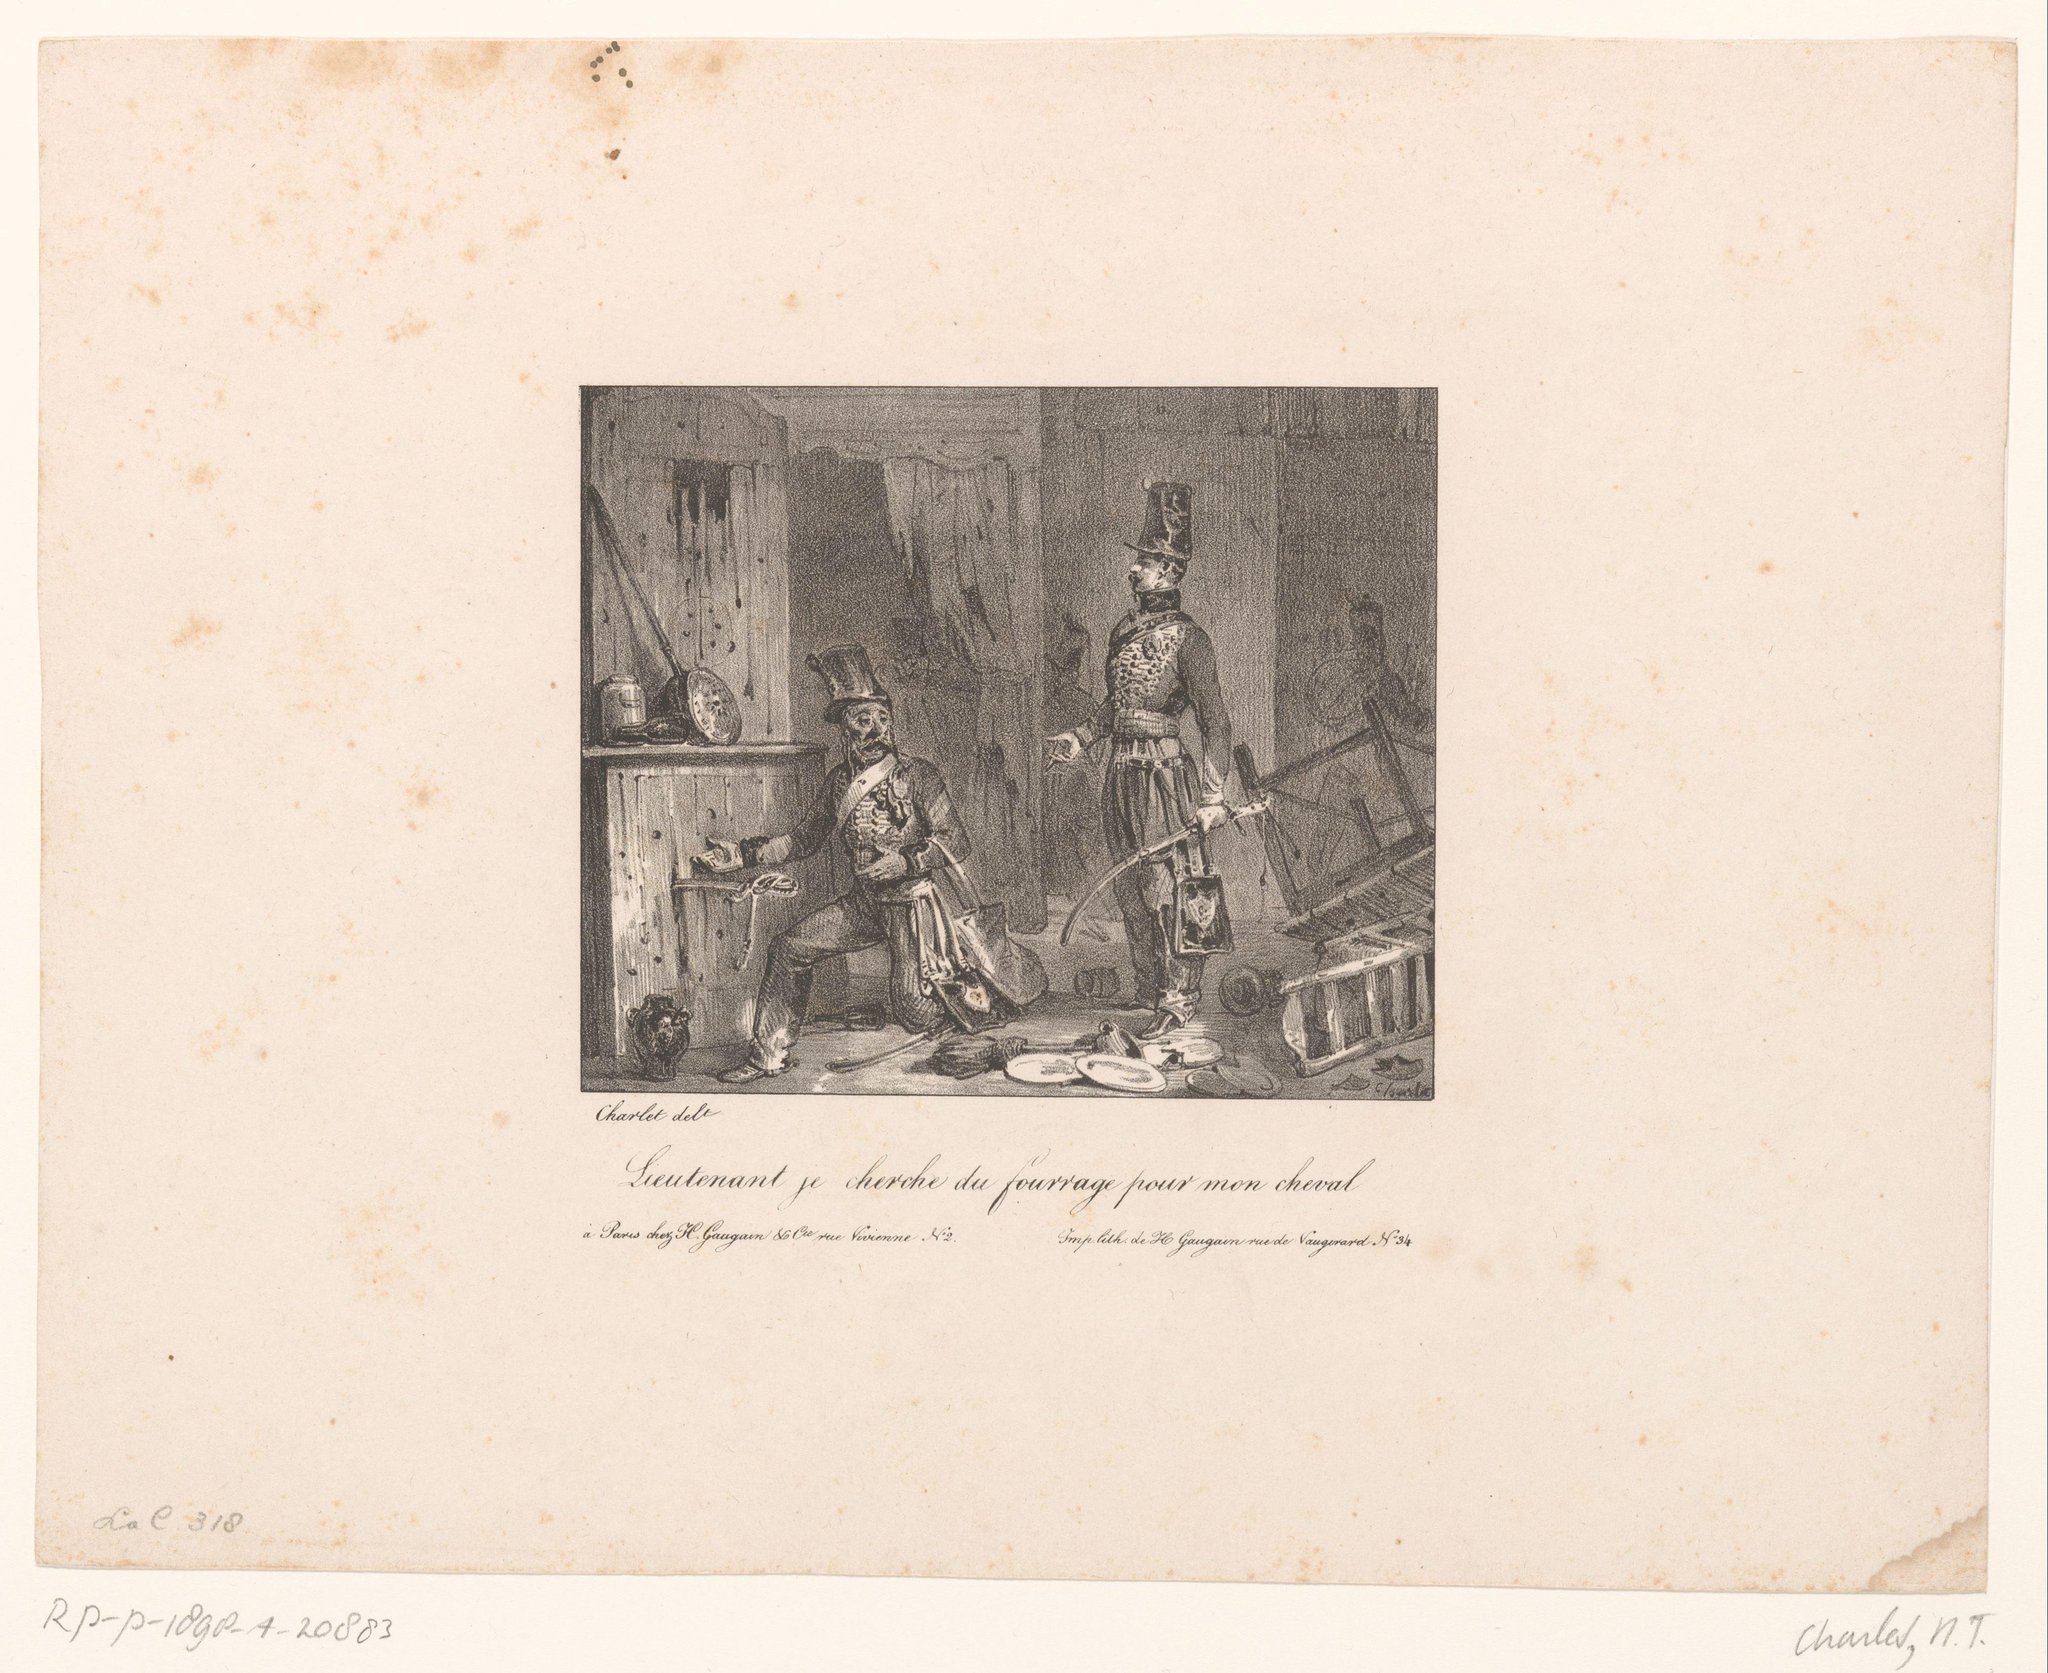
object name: print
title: Lieutenant, je cherche du fourrage pour mon cheval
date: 1828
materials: paper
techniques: lithograph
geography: paris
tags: mess ~ the soldier off duty, plundering ~ soldiers, interior of the house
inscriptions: collector's mark: Lugt 2228a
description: De soldaat heeft zijn degen in een betimmering aan de muur gestoken. Het interieur is overhoop gehaald. Als verklaring zegt hij tegen de luitenant dat hij hooi zoekt voor zijn paard.